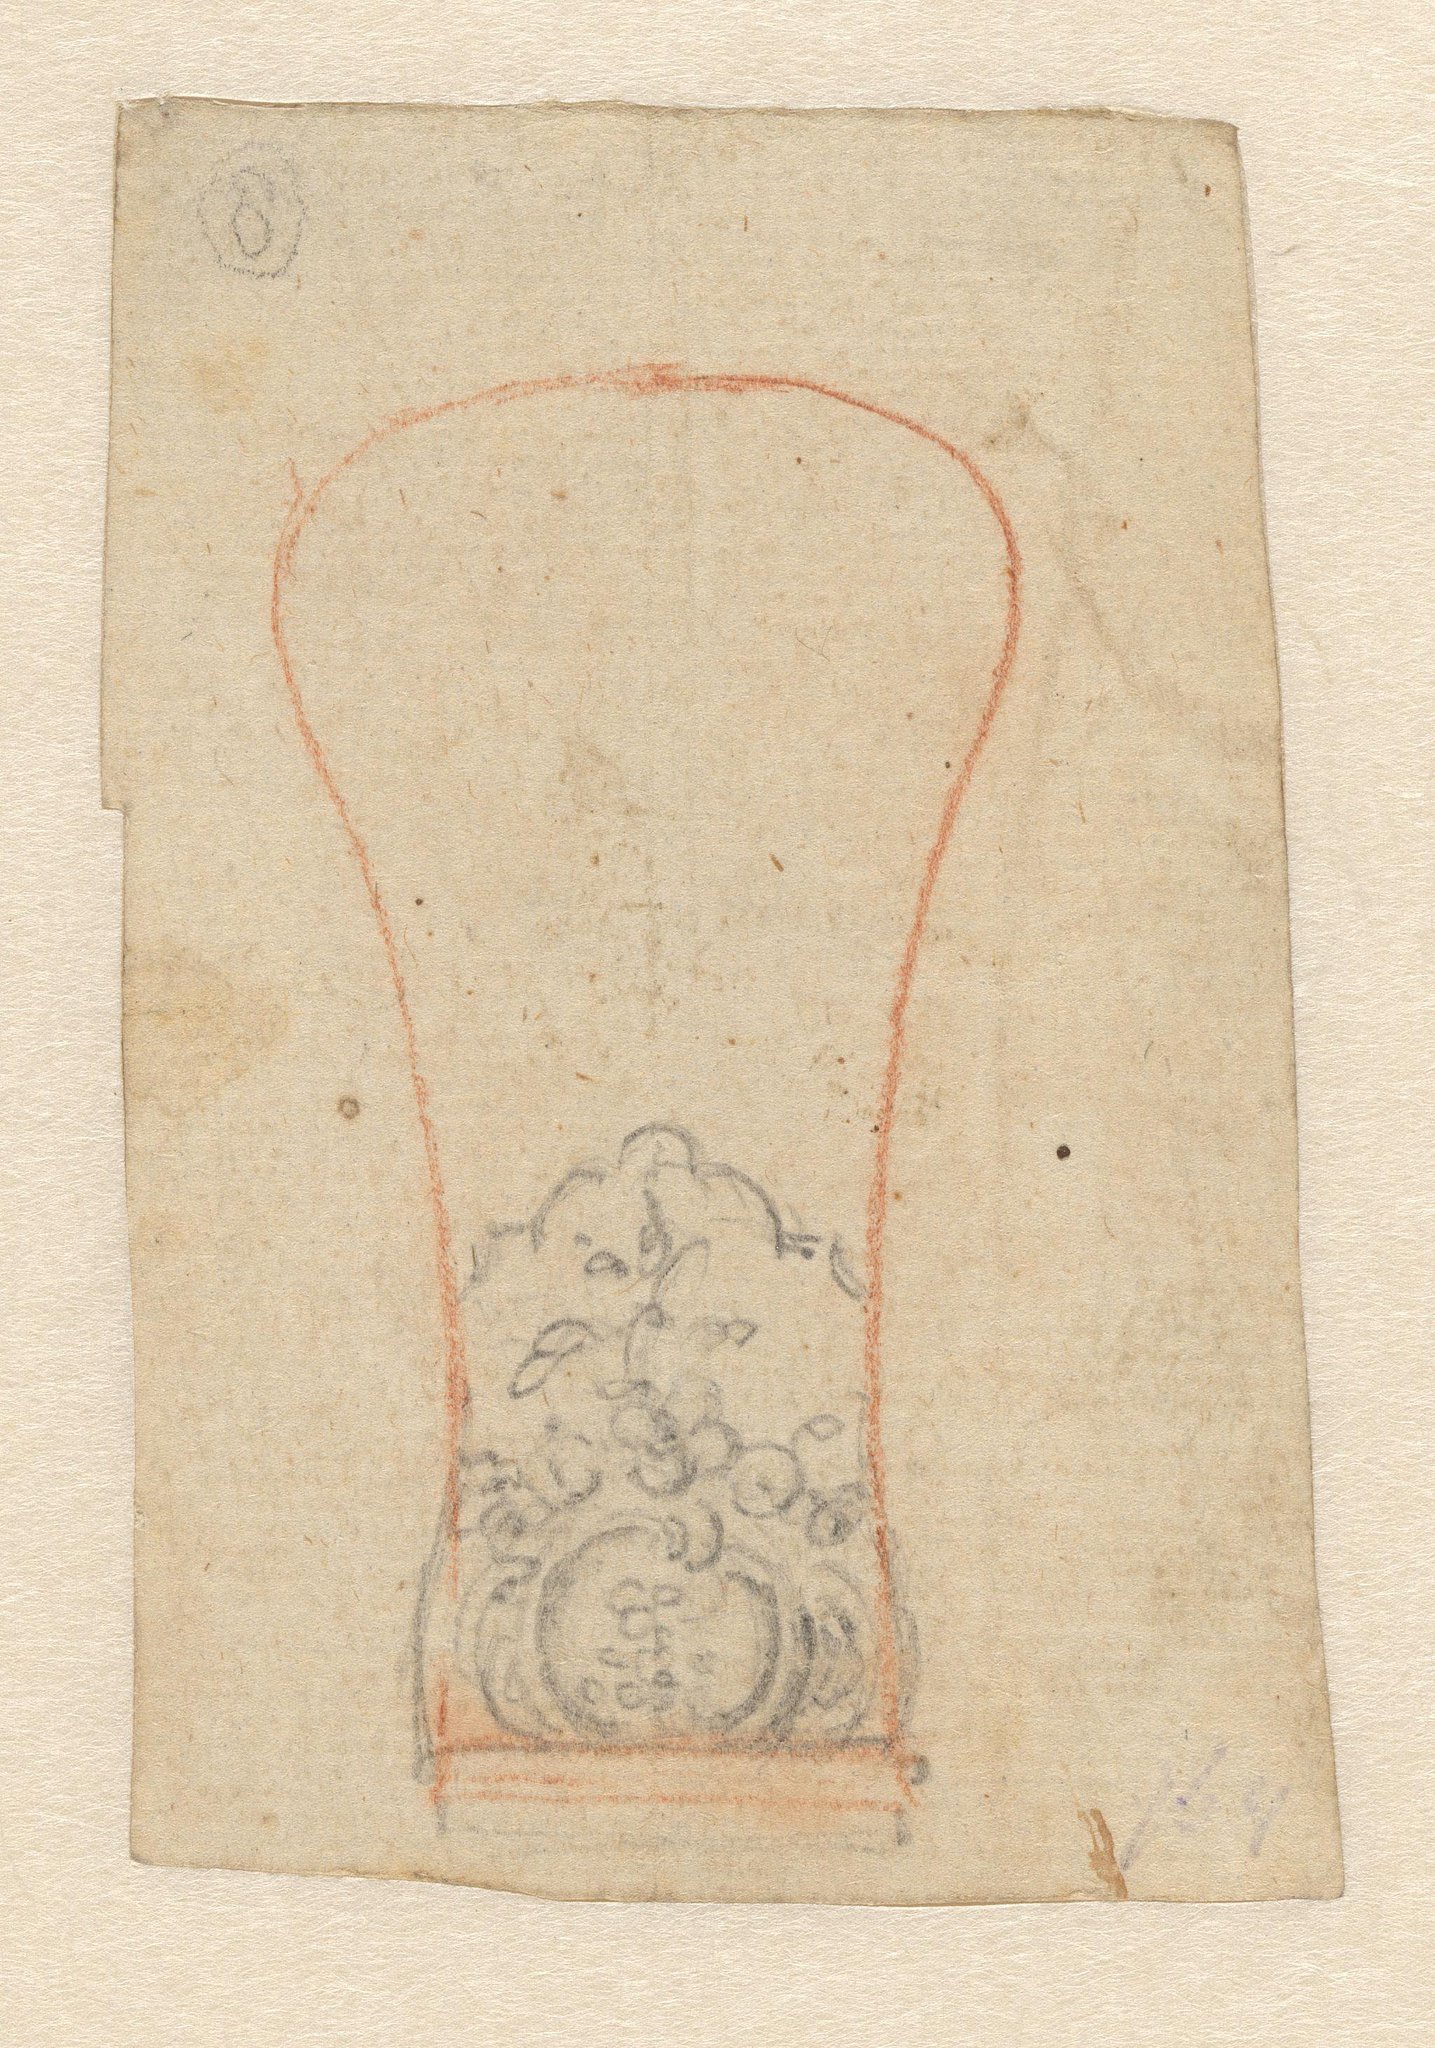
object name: design drawing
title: Ontwerp voor een wandelstokknop met bloemmotieven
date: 1740-1760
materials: chalk, paper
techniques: drawing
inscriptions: inscription: ‘8’, inscription: ‘964’